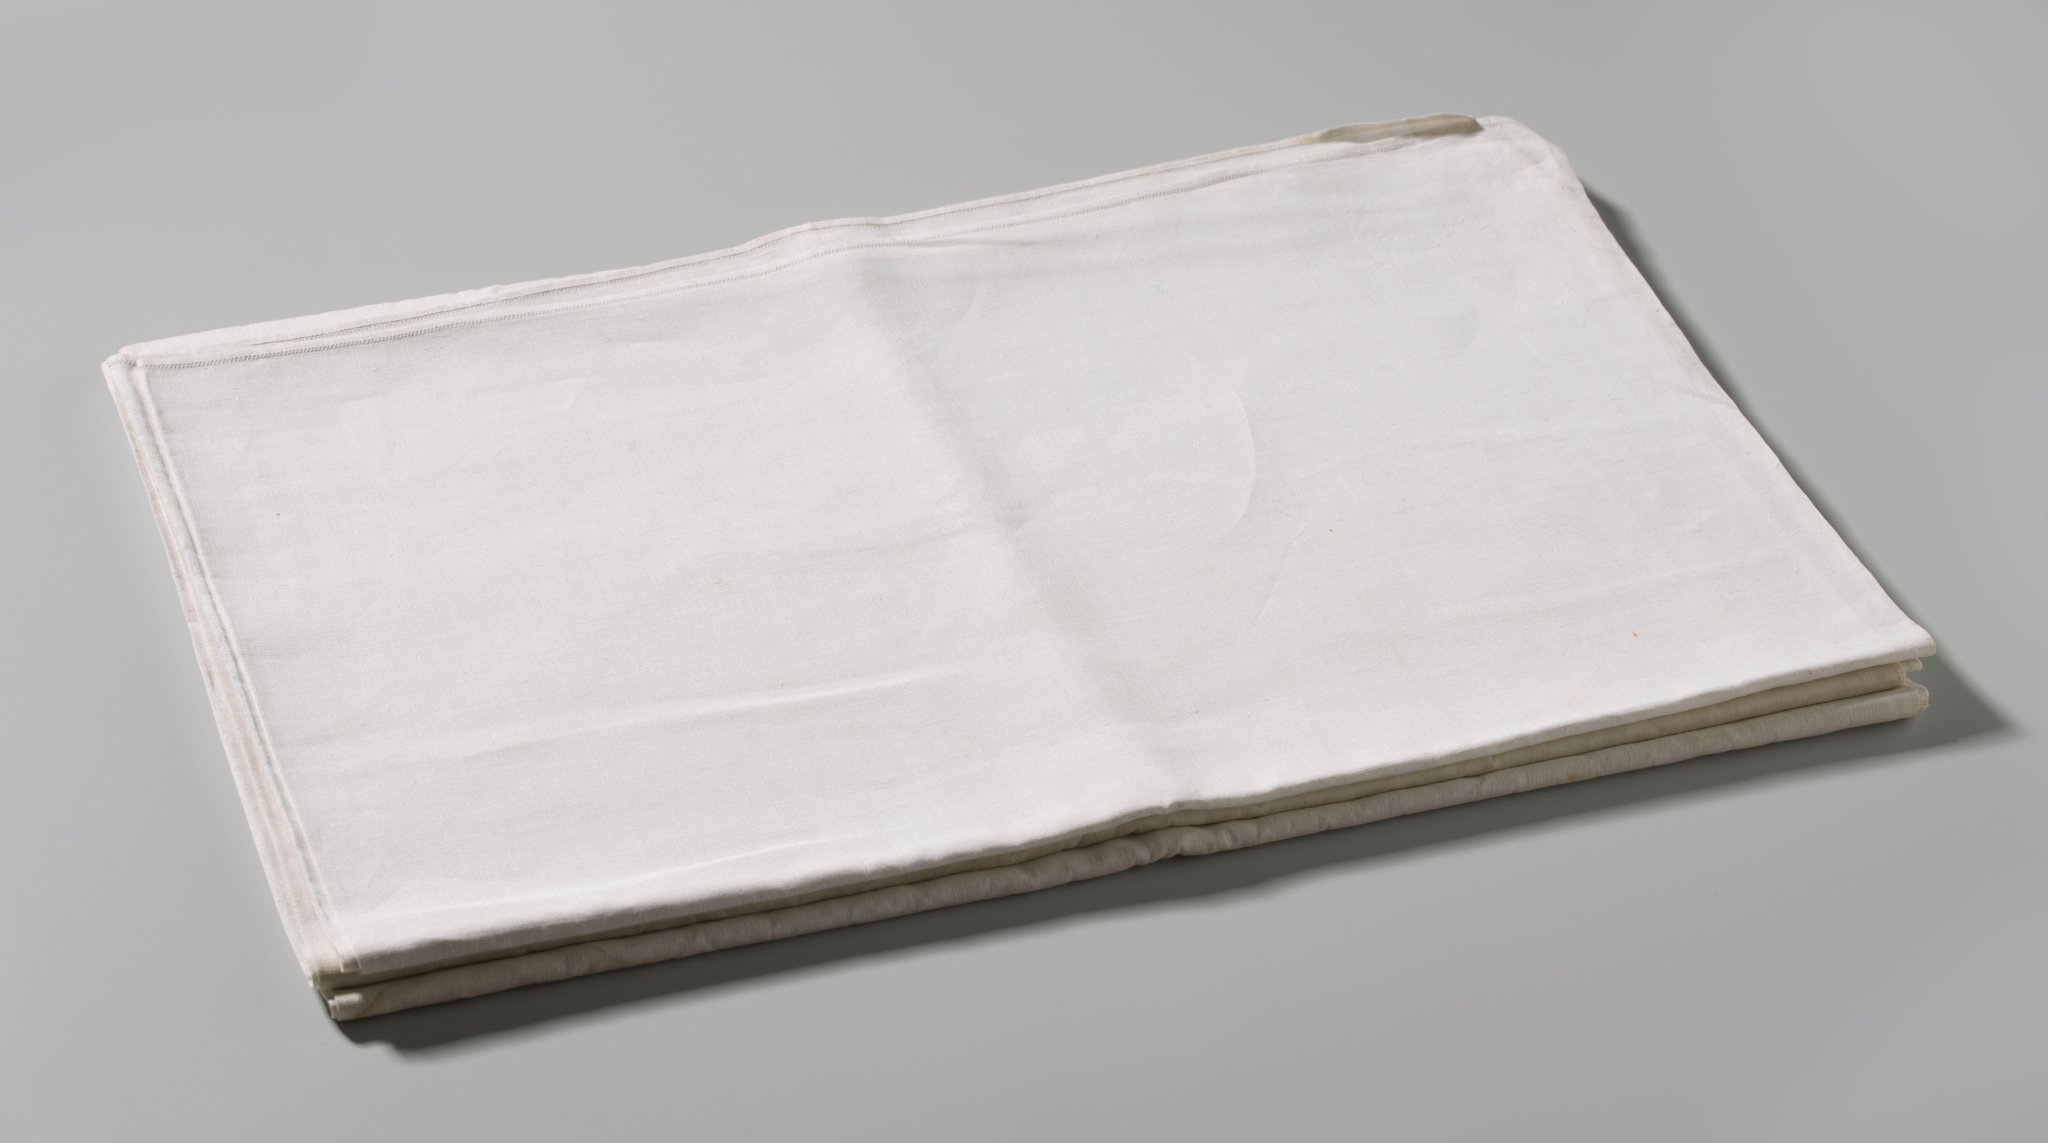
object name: tablecloth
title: Tafellaken van linnendamast met een historisch tafereel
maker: Anonymous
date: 1717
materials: linen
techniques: damask, weave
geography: flanders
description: Wit linnen damasten tafellaken met de overwinningen op de Turken door Eugenius van Savoye onder Karel VI van Oostenrijk. Gemerkt T C 3. Het veld heeft van onder naar boven de afbeeldingen: strijdende ruiters, een stad met opschrift BELGRADEN, een ruiter met aan weerszijden een boom met brandende vetpotten en het wapen van Spanje met een lint waarop de tekst: CAROLUS..(zie ook BK-16806).